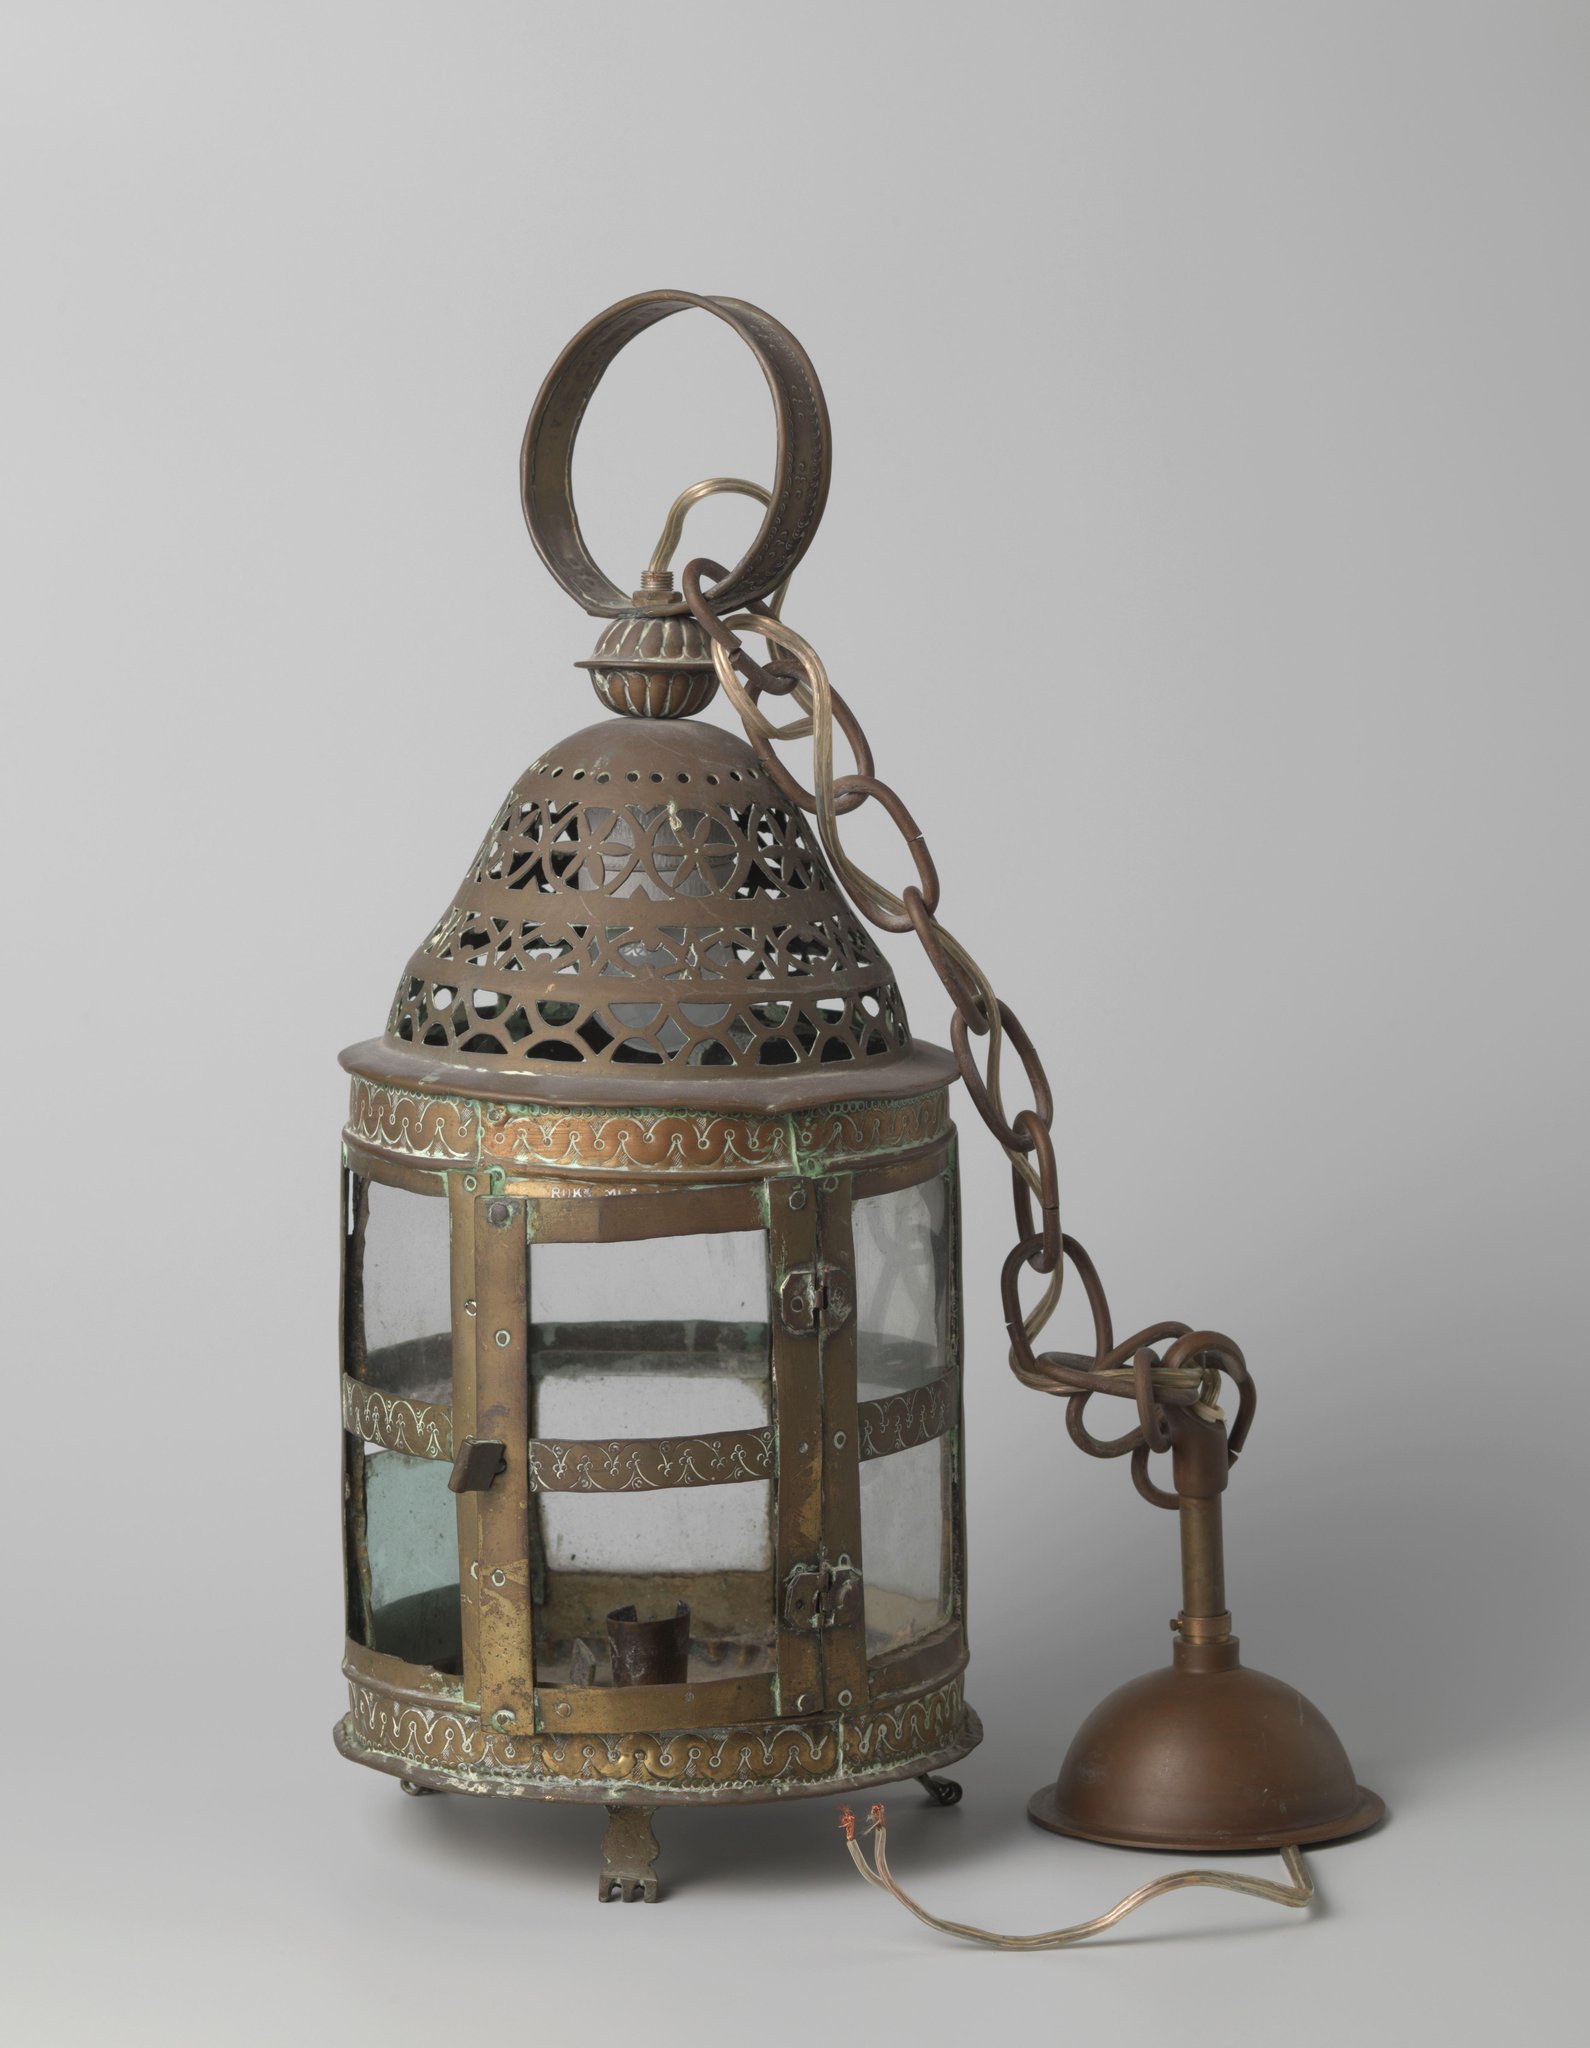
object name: lantern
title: Lantaarn van koper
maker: Anonymous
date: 1400-1950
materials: copper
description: Lantaarn van koper. Zestien ramen. Voorzien van elektriciteitsdraad en fitting ten behoeve van gloeilamp.